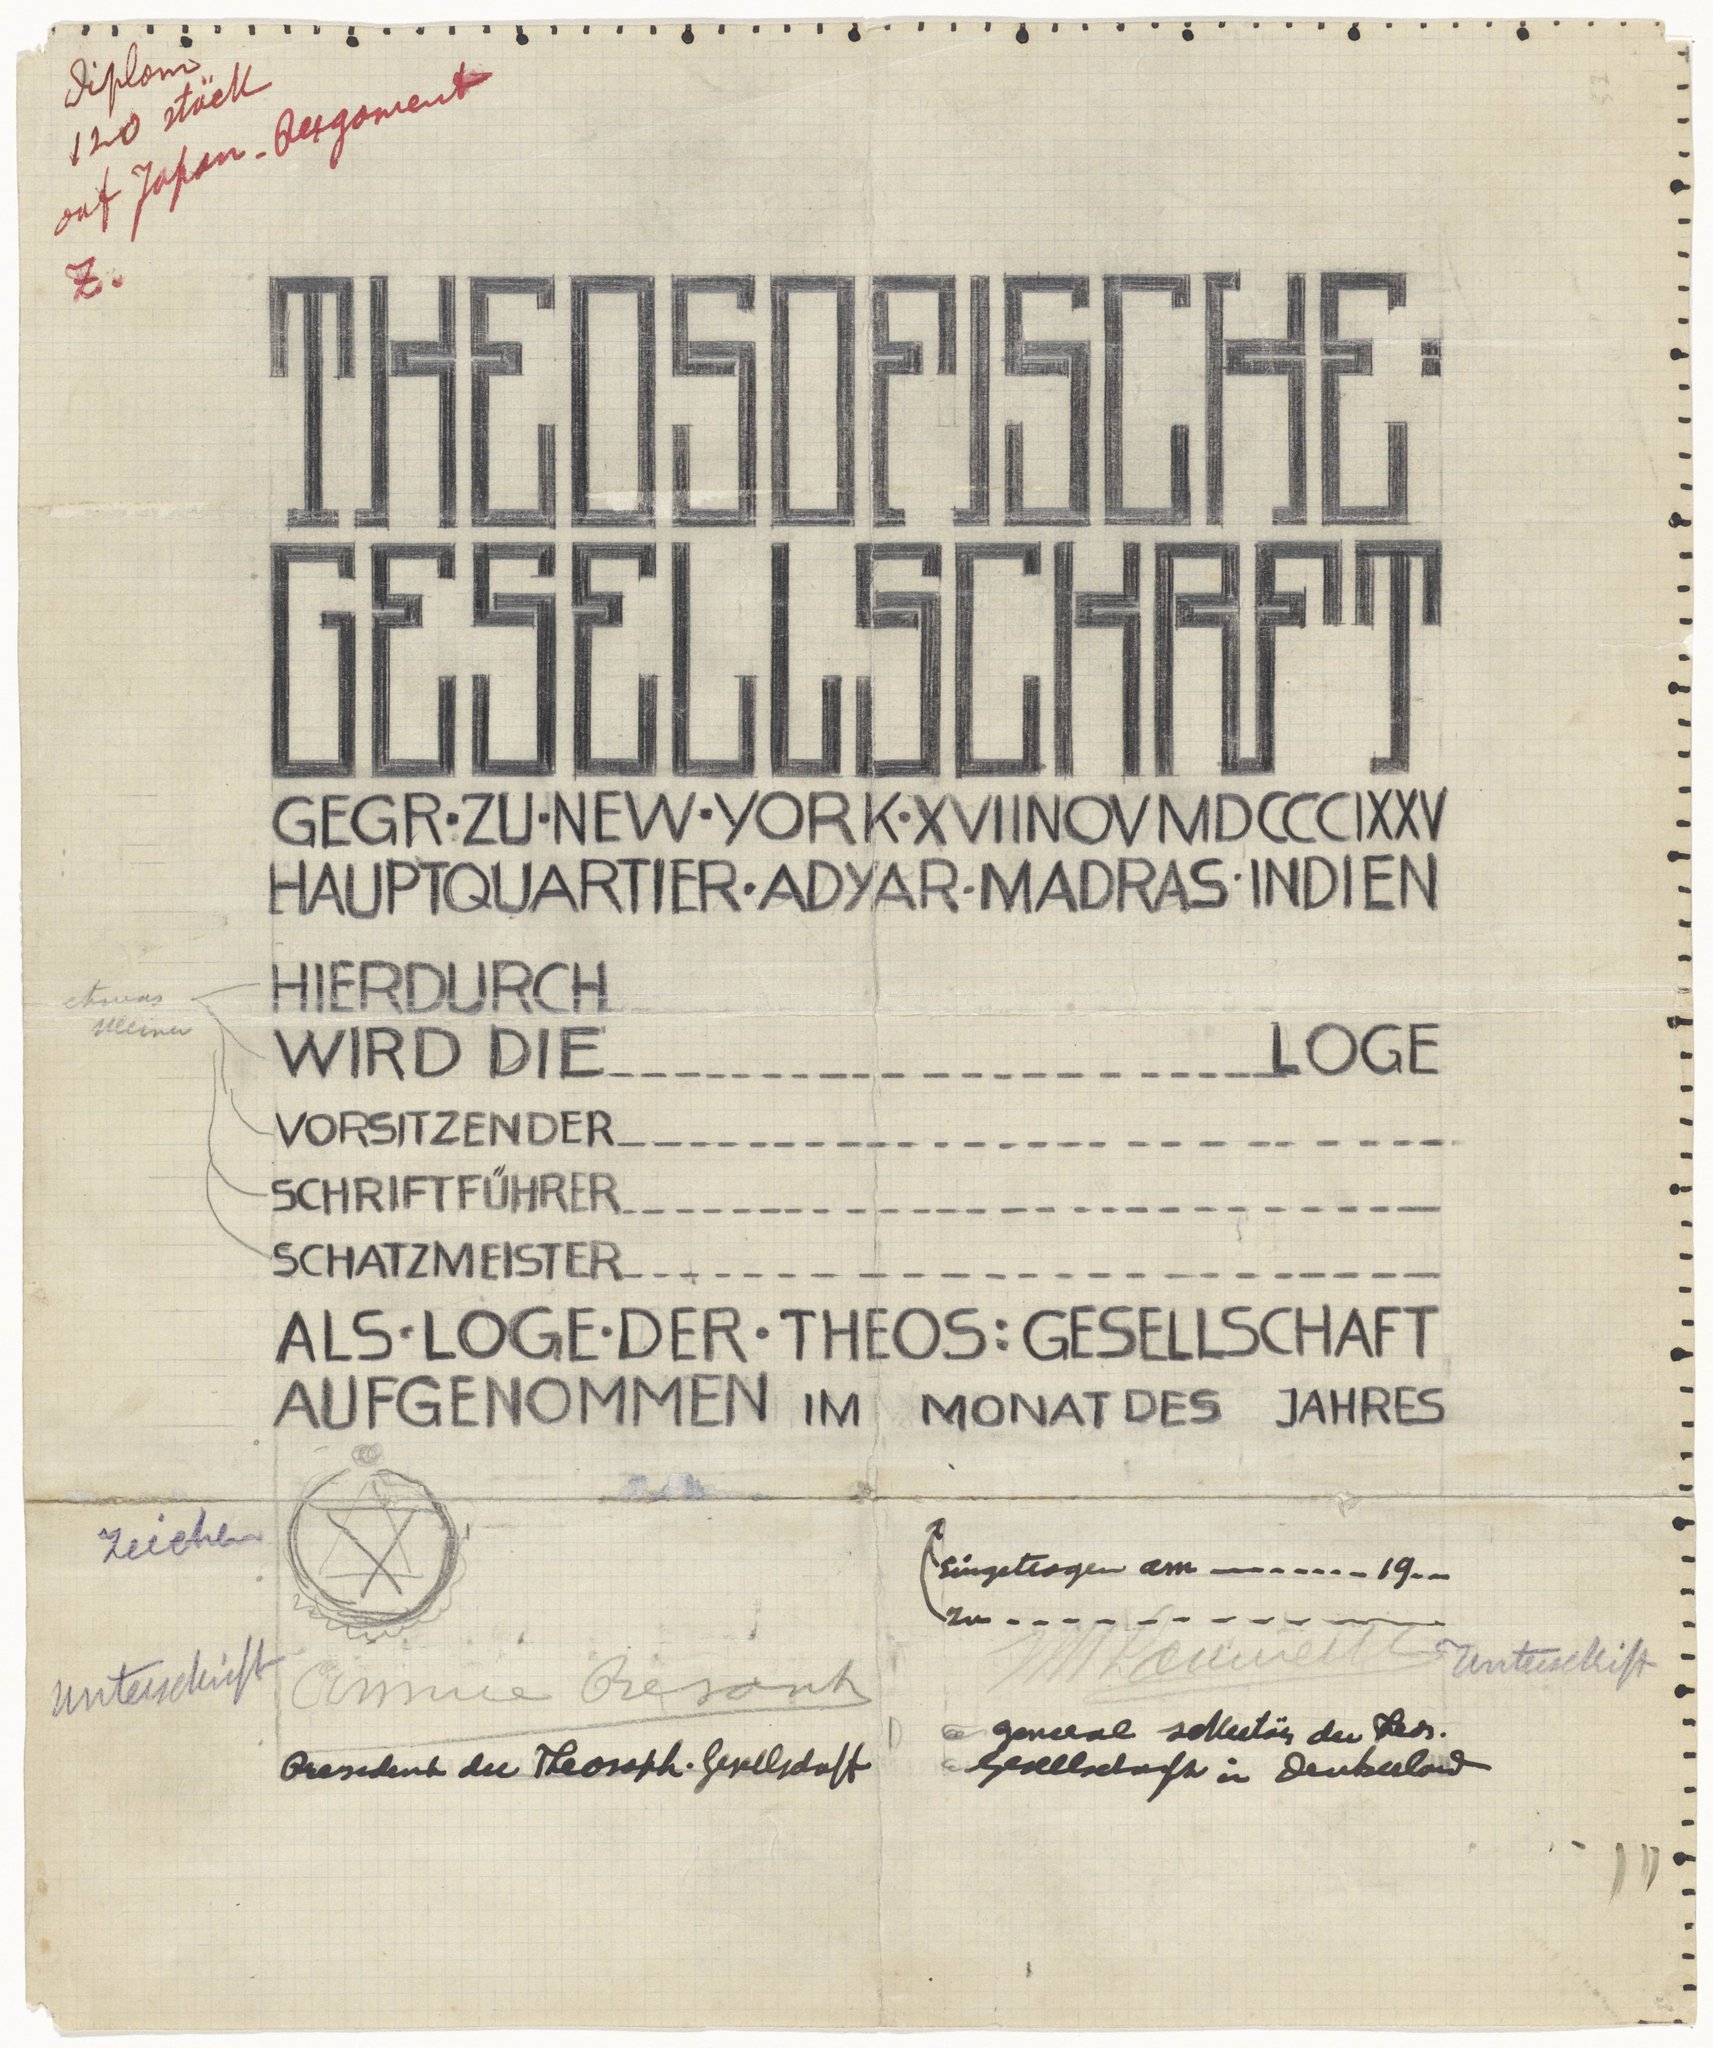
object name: design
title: Ontwerp voor een diploma van de Theosofische Gesellschaft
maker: mathieu lauweriks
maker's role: designer, draughtsman, print maker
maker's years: 1864-1932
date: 1874-1932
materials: ink, pencil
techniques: pen